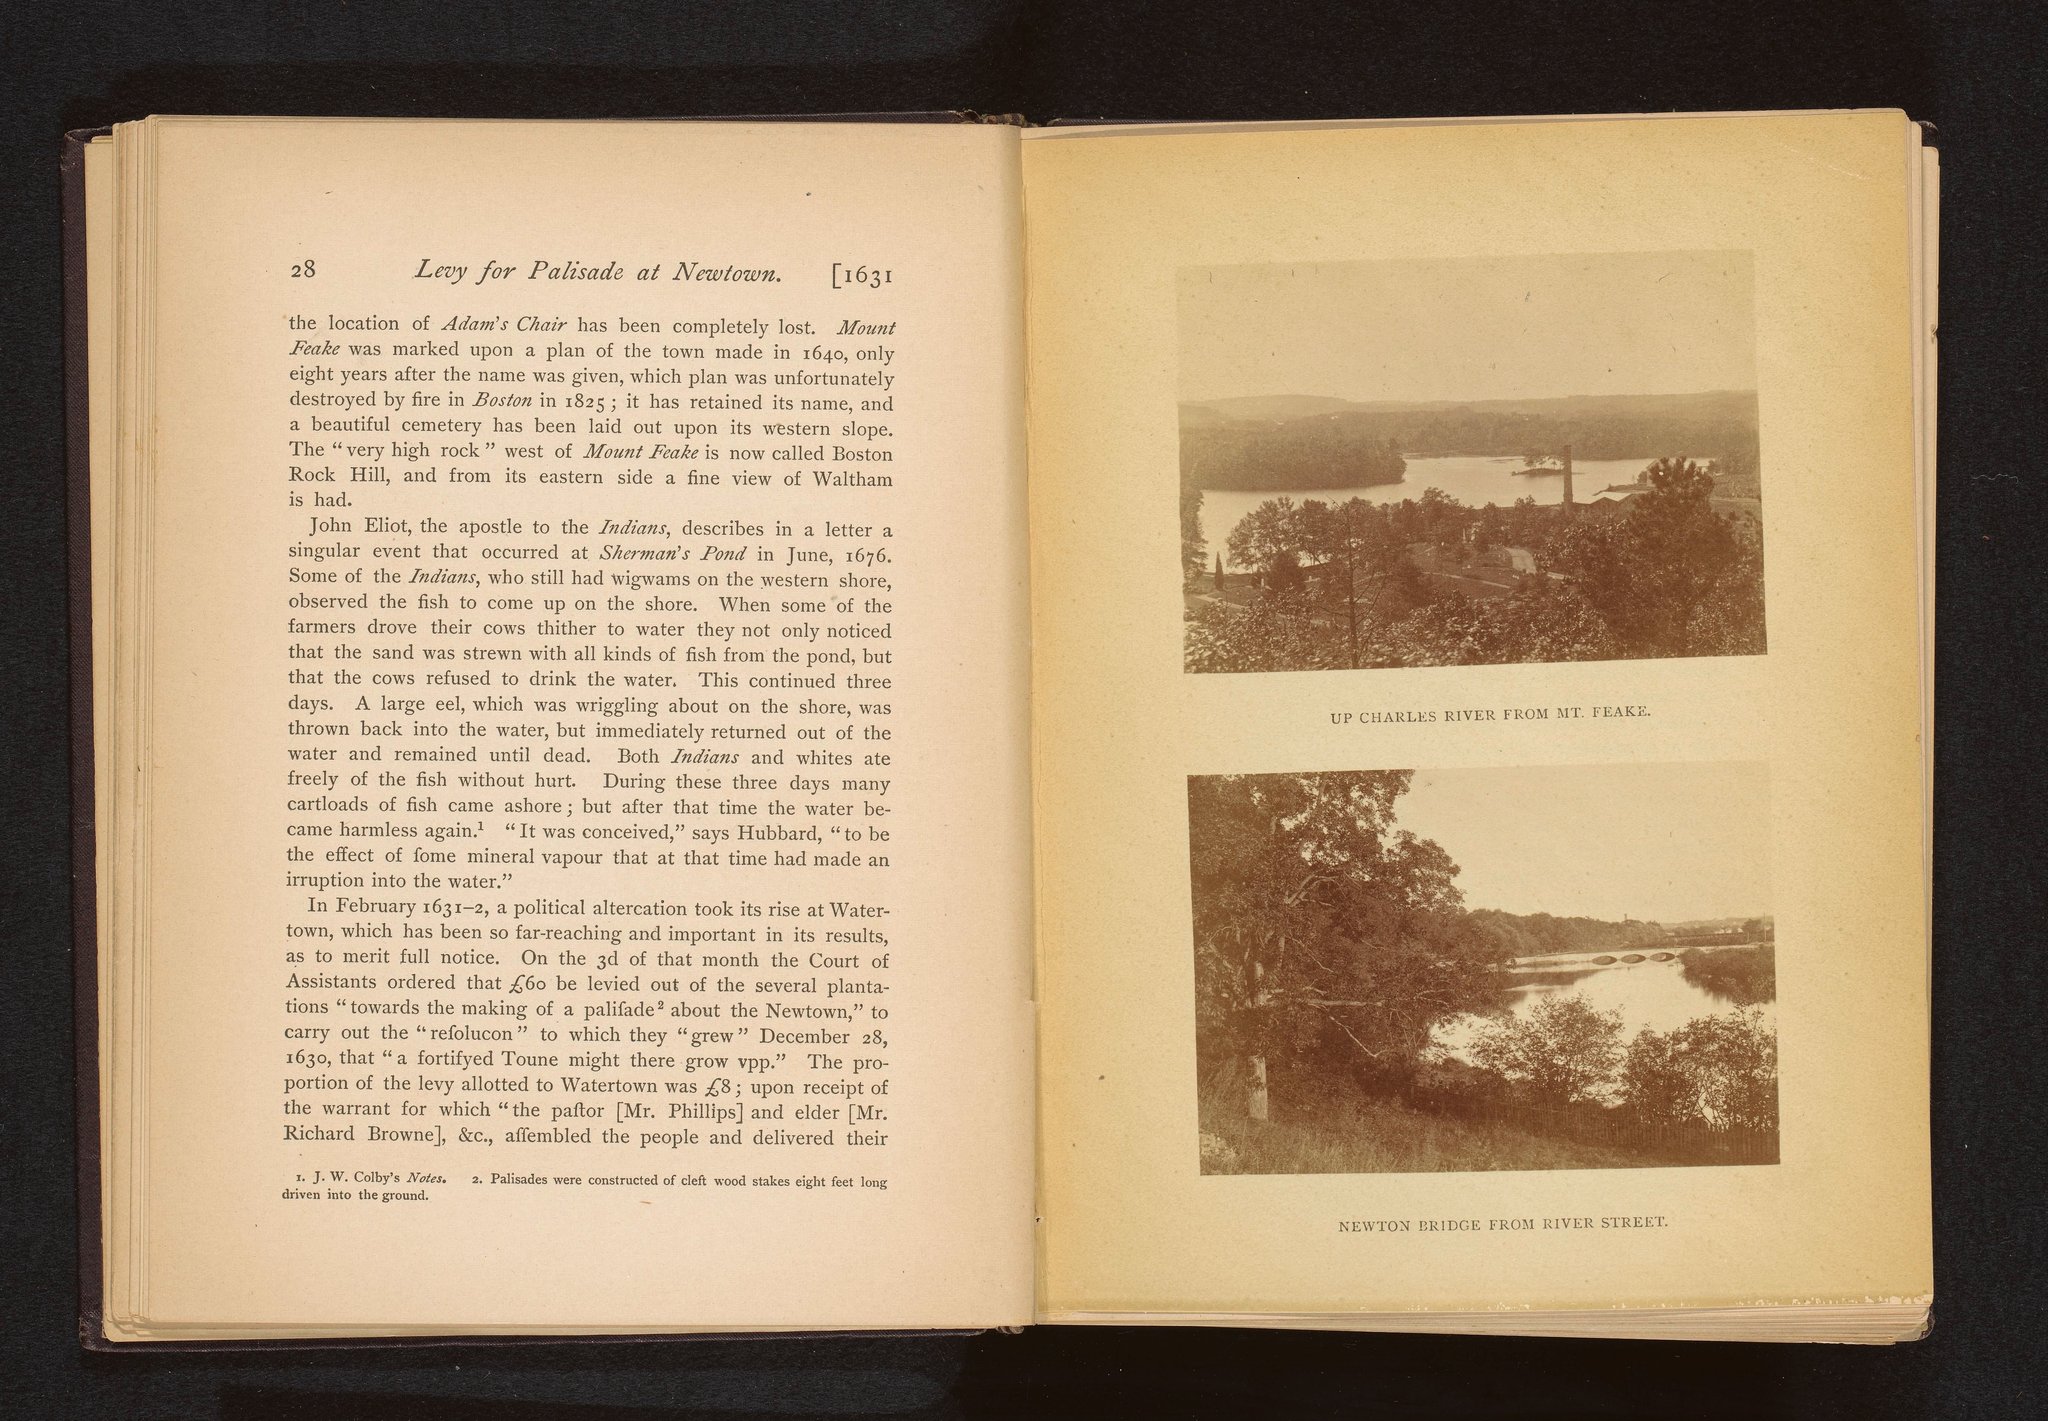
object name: photograph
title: Newton Bridge from River Street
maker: thomas r. lewis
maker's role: publisher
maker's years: 1845-1901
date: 1874-1879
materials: photographic support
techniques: albumen print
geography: waltham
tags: river, bridge